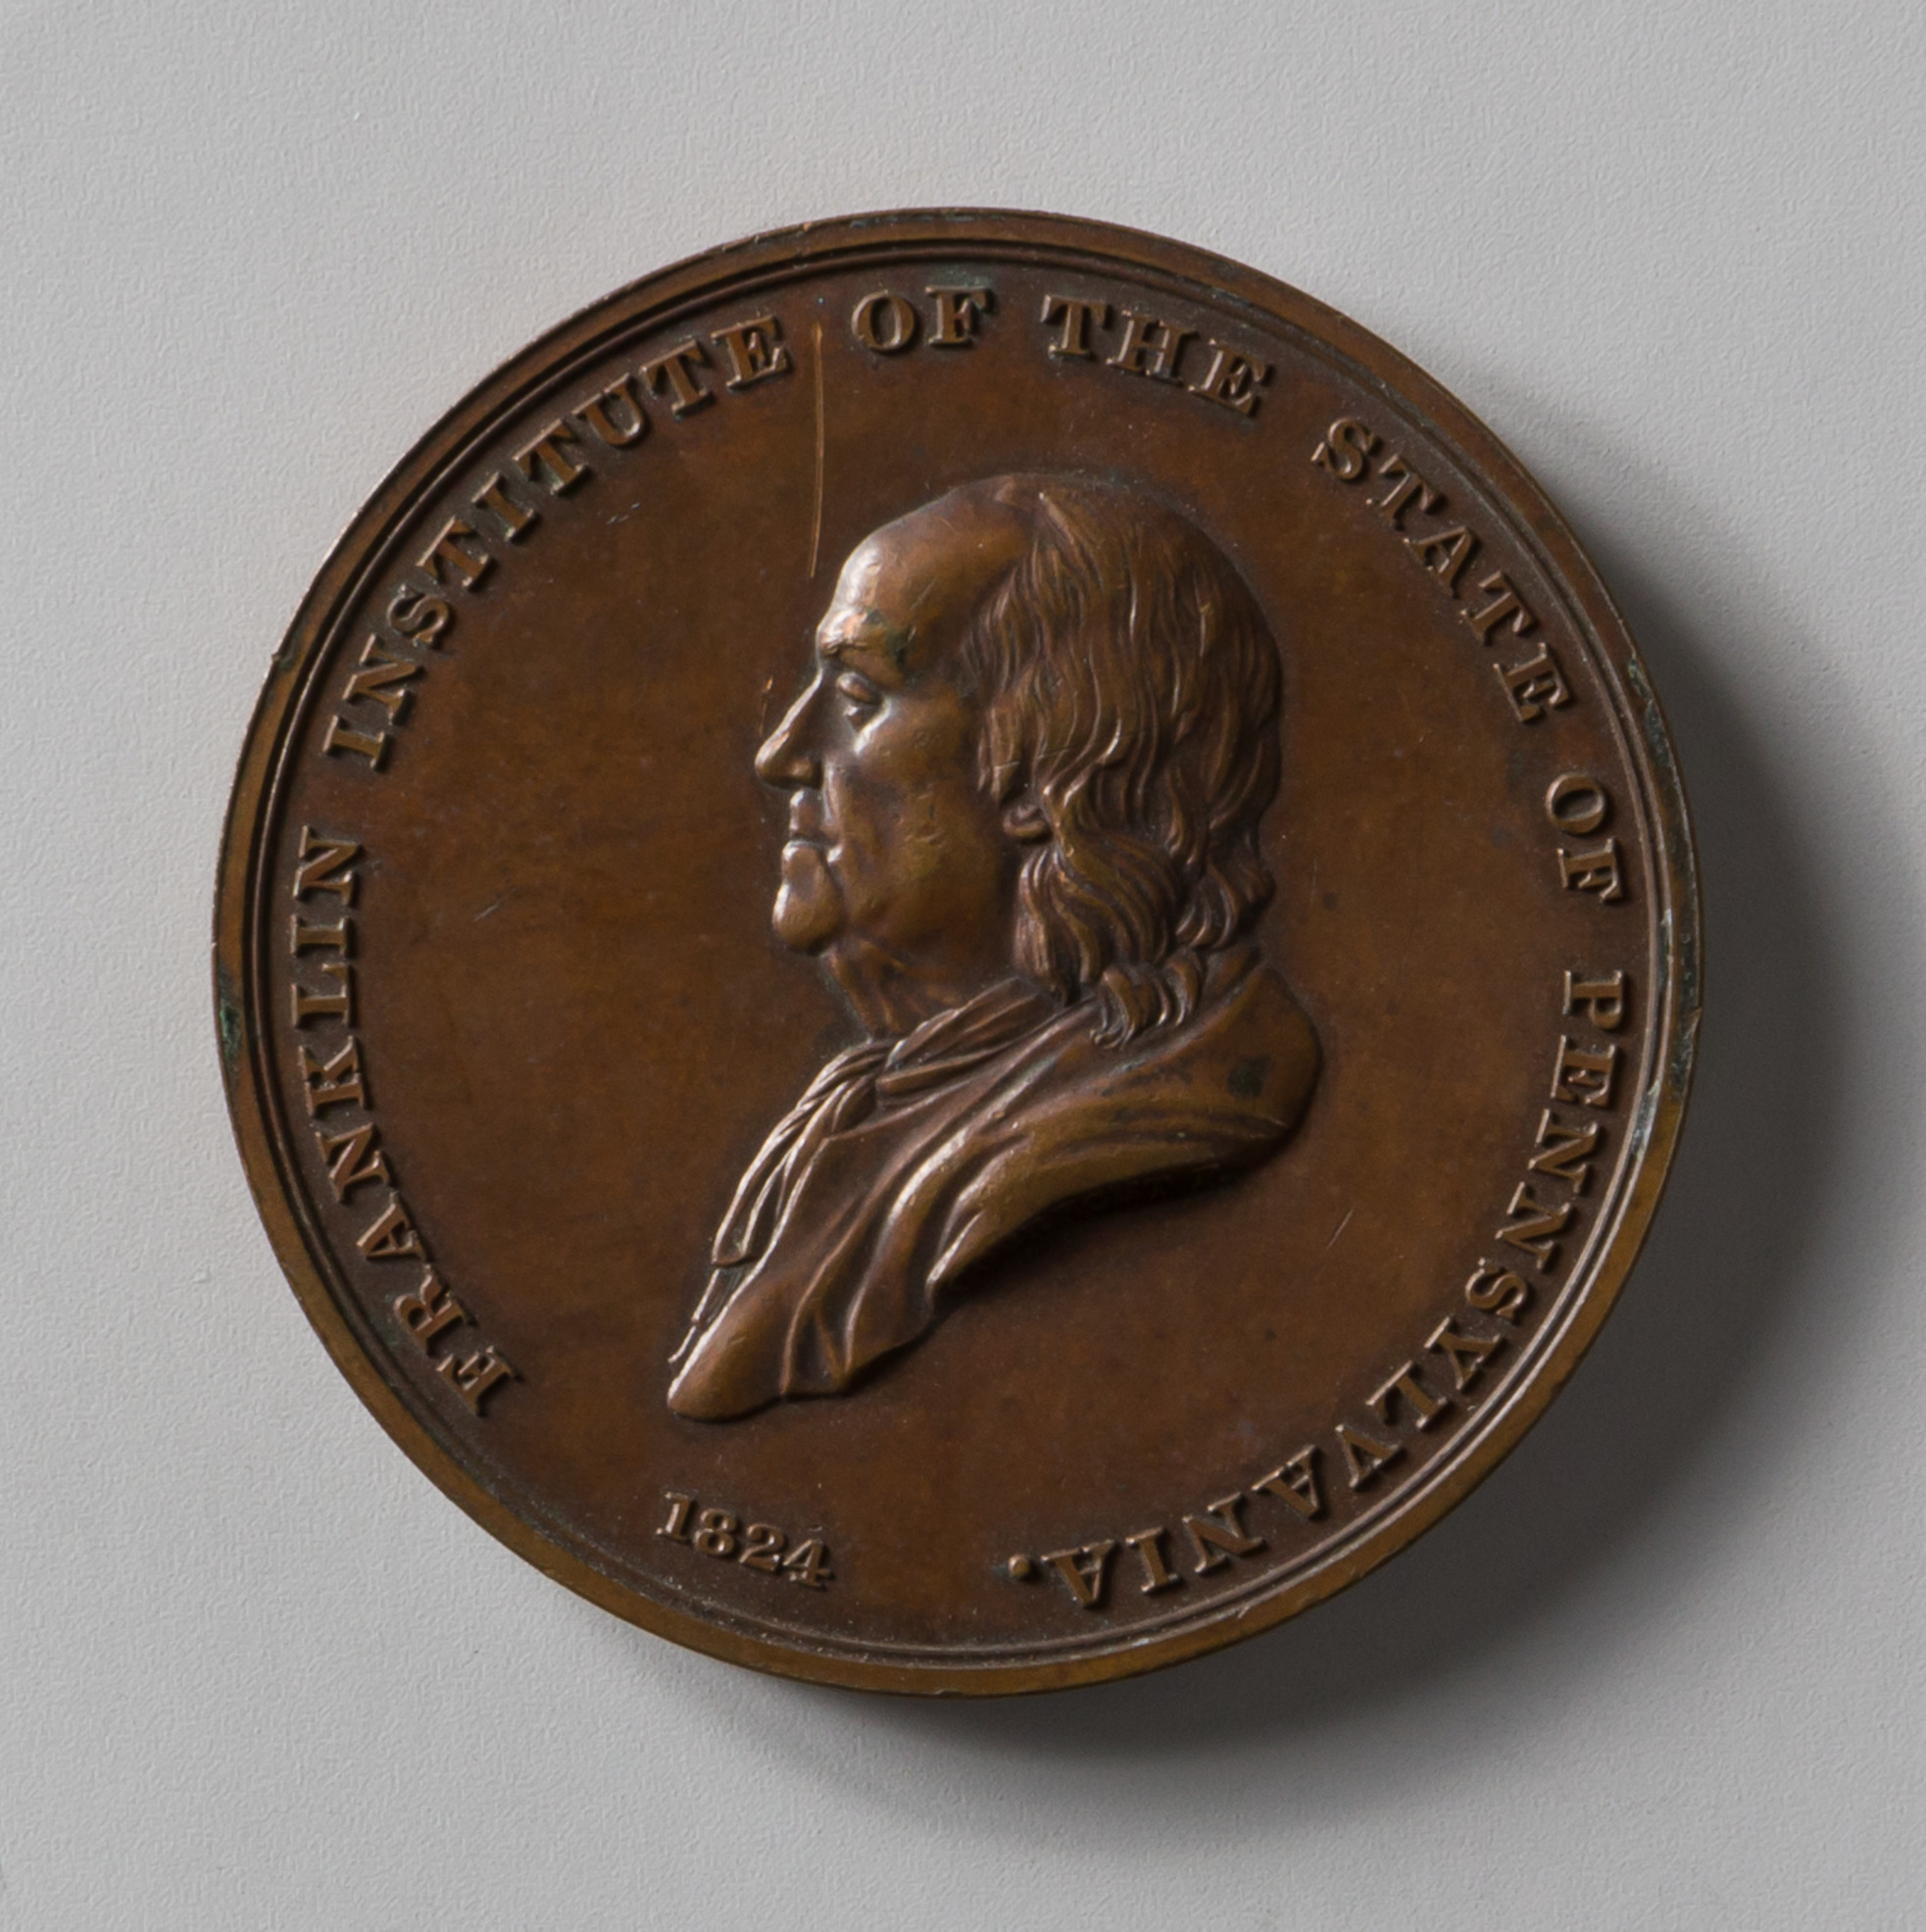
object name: medallion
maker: christian gobrecht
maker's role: maker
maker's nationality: american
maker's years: 1785-1844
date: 1824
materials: bronze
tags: benjamin franklin,men,profiles